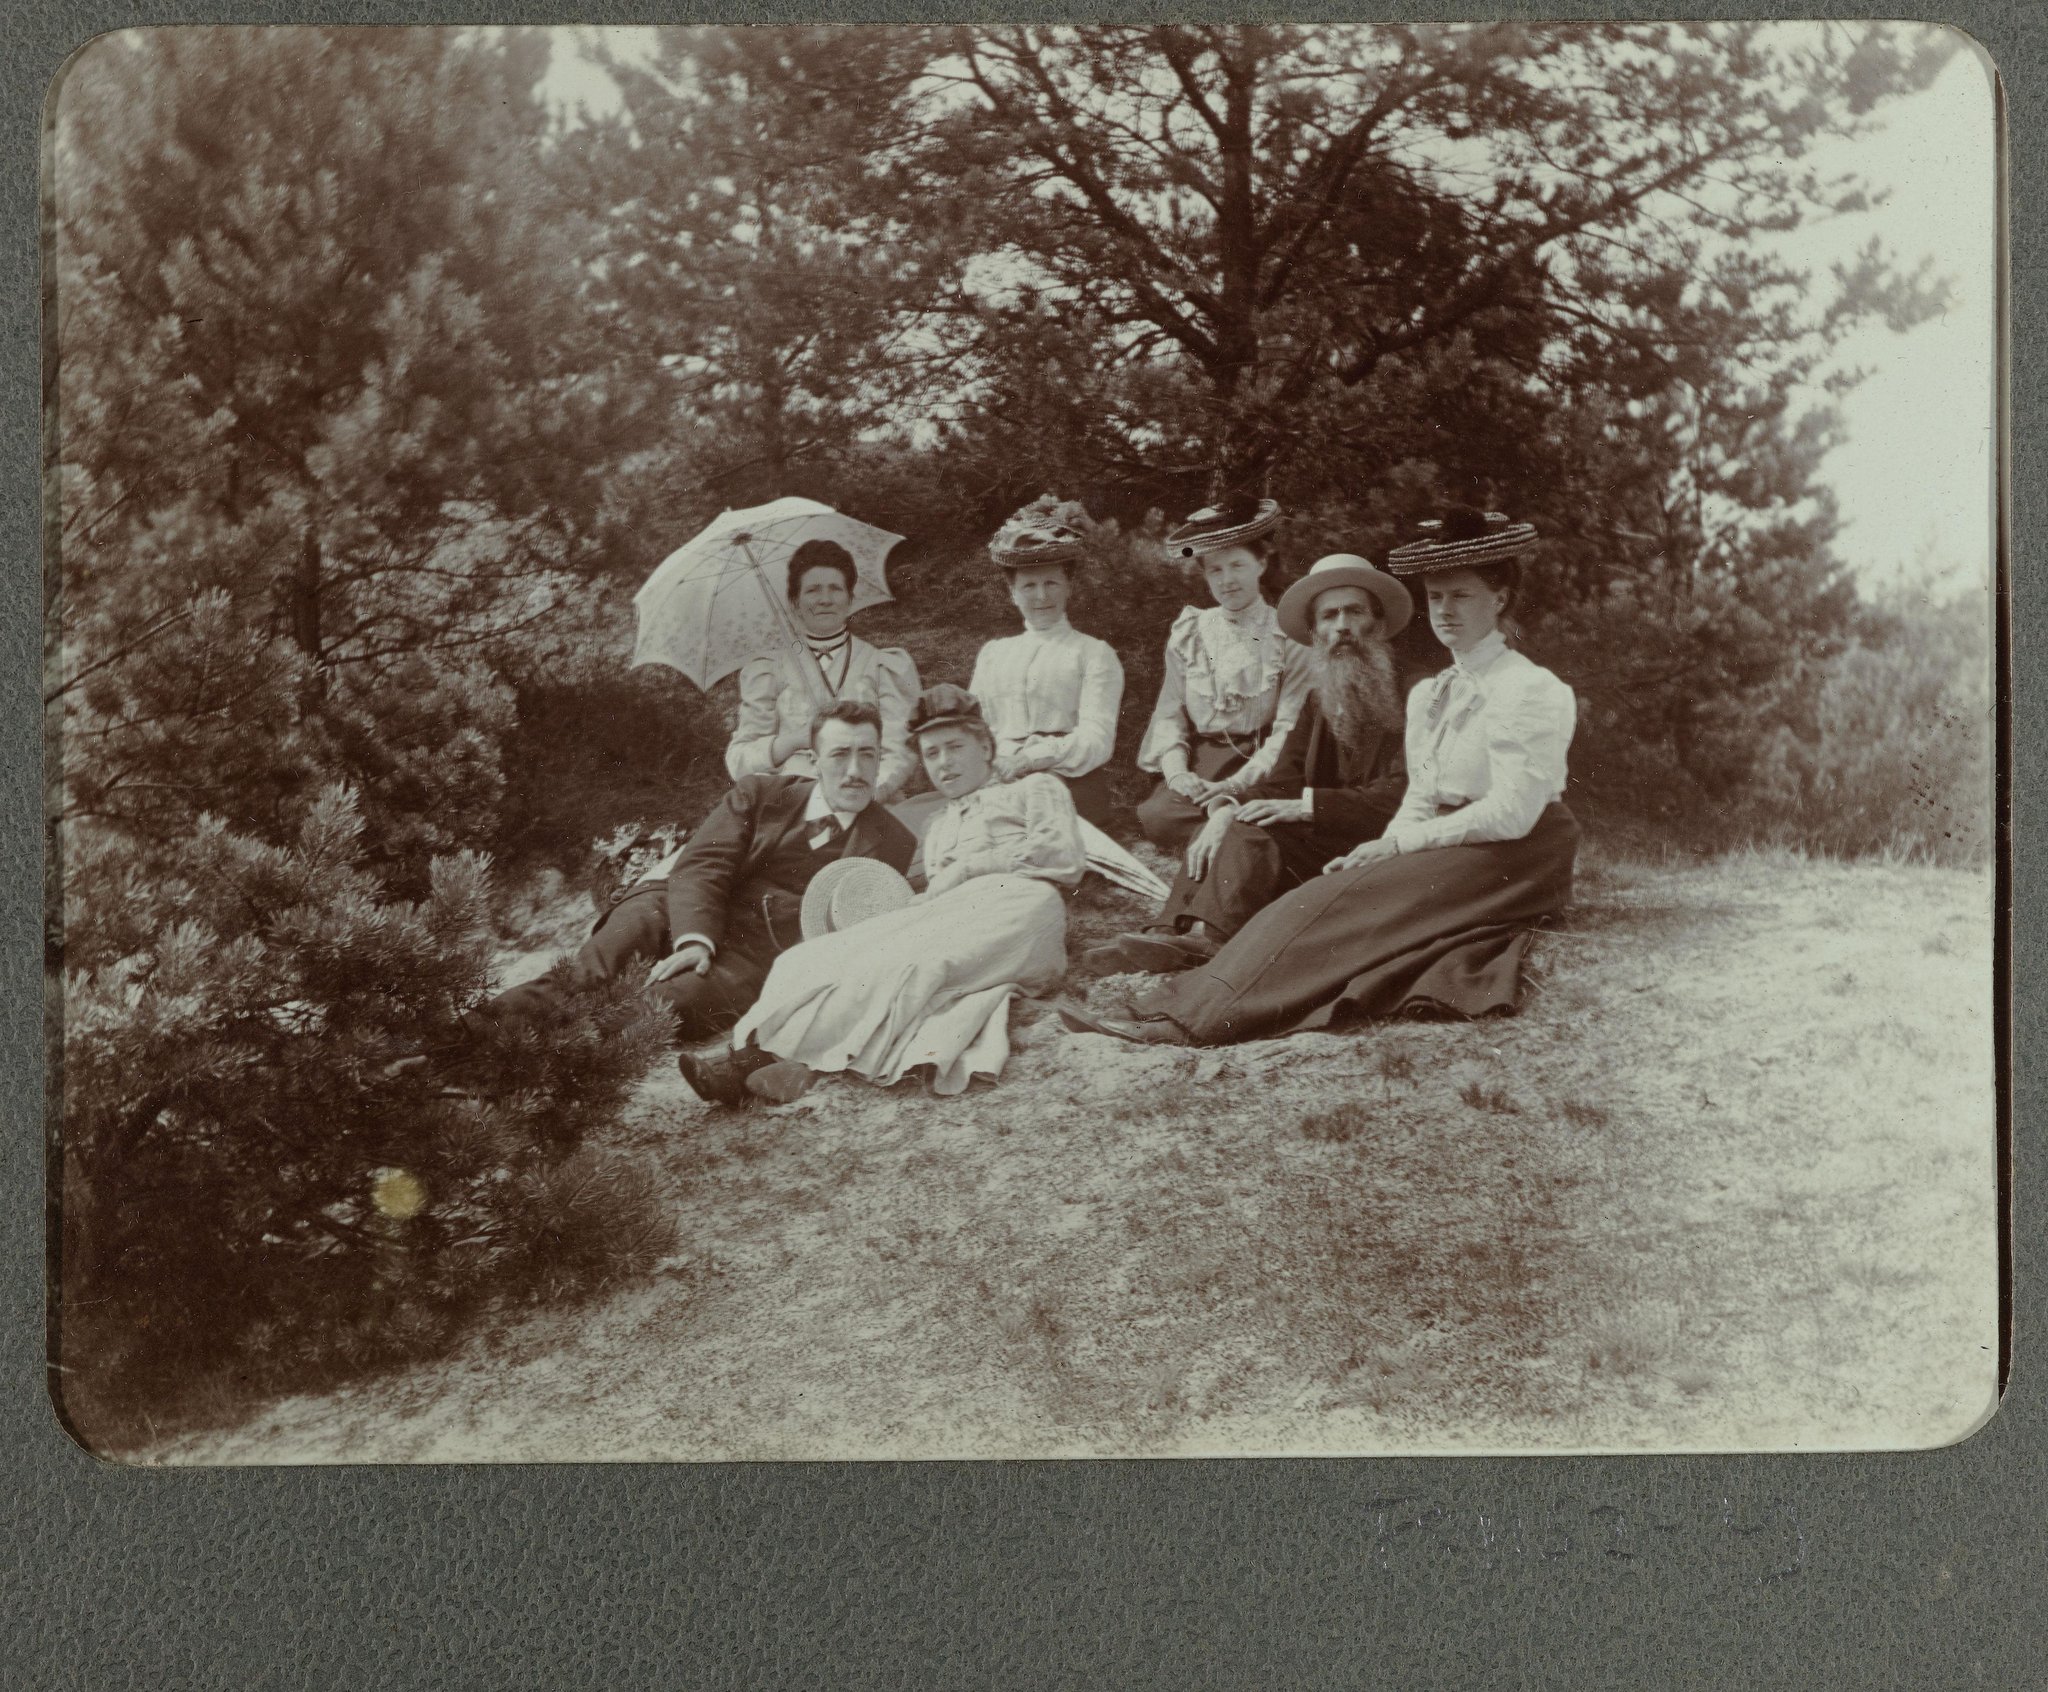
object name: photograph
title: Familieportret op de heide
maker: christiaan otto roelofs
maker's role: fotograaf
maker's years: 1882-1970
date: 1900-1915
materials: photographic support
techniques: gelatin silver print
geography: netherlands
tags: historical persons, open-air recreation